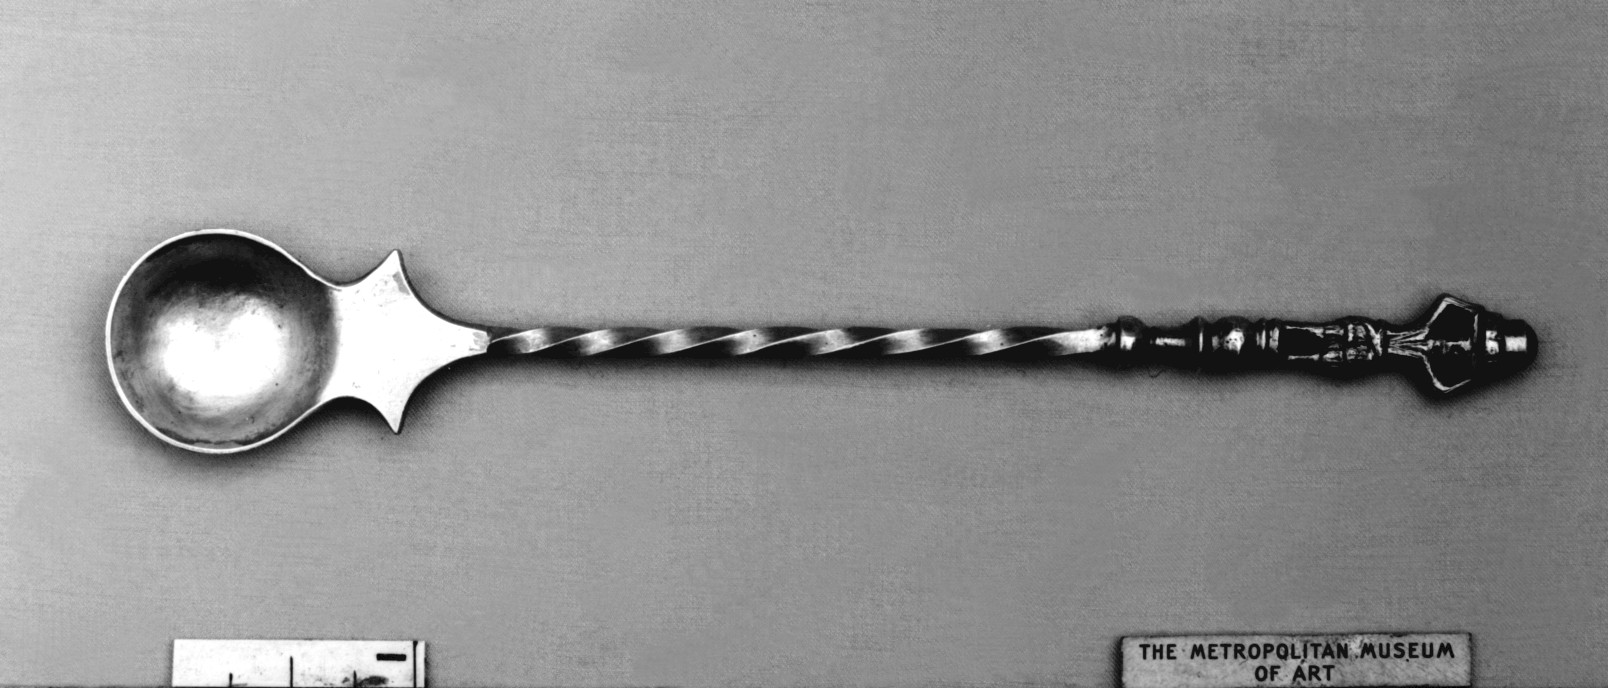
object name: spoon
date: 1801-1900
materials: gilt, silver